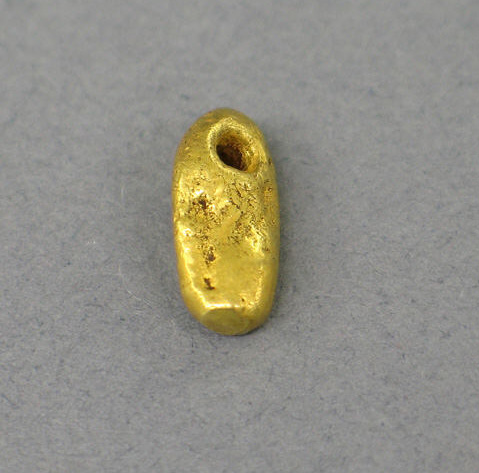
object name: pendant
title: Small Pendant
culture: indonesian, javanese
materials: gold